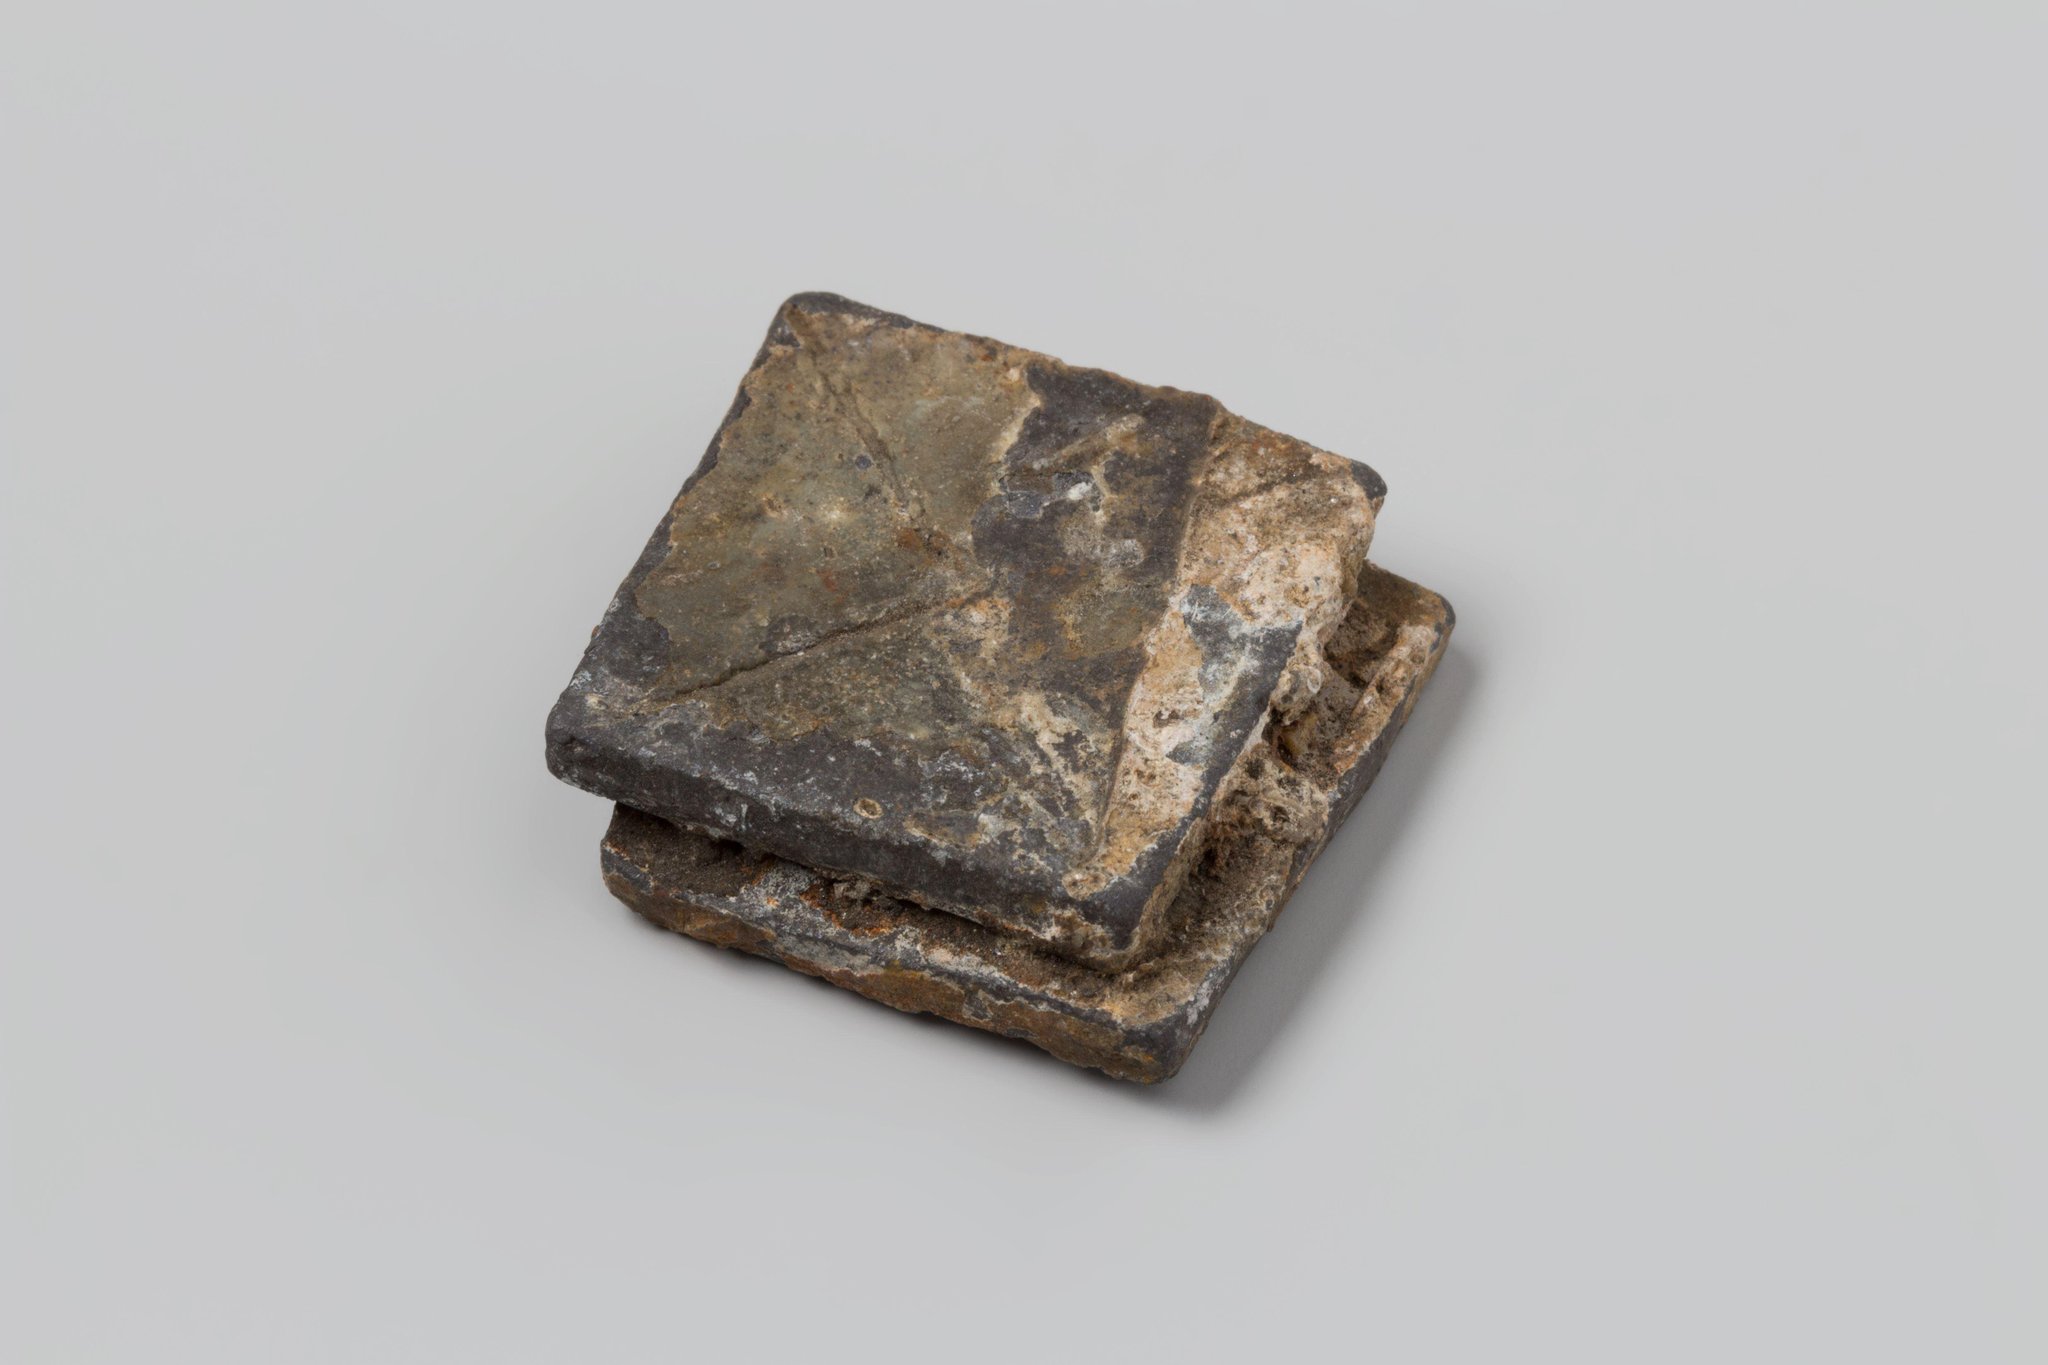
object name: gaming counter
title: Speelpenning uit het wrak van de Oost-Indiëvaarder Hollandia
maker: Anonymous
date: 1700-1743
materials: lead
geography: netherlands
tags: verenigde oostindische compagnie, hollandia (schip), annet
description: Rectangular, square, flat, engraved diagonal cross on one side, game token. Zit vast aan NG-1979-330-H.